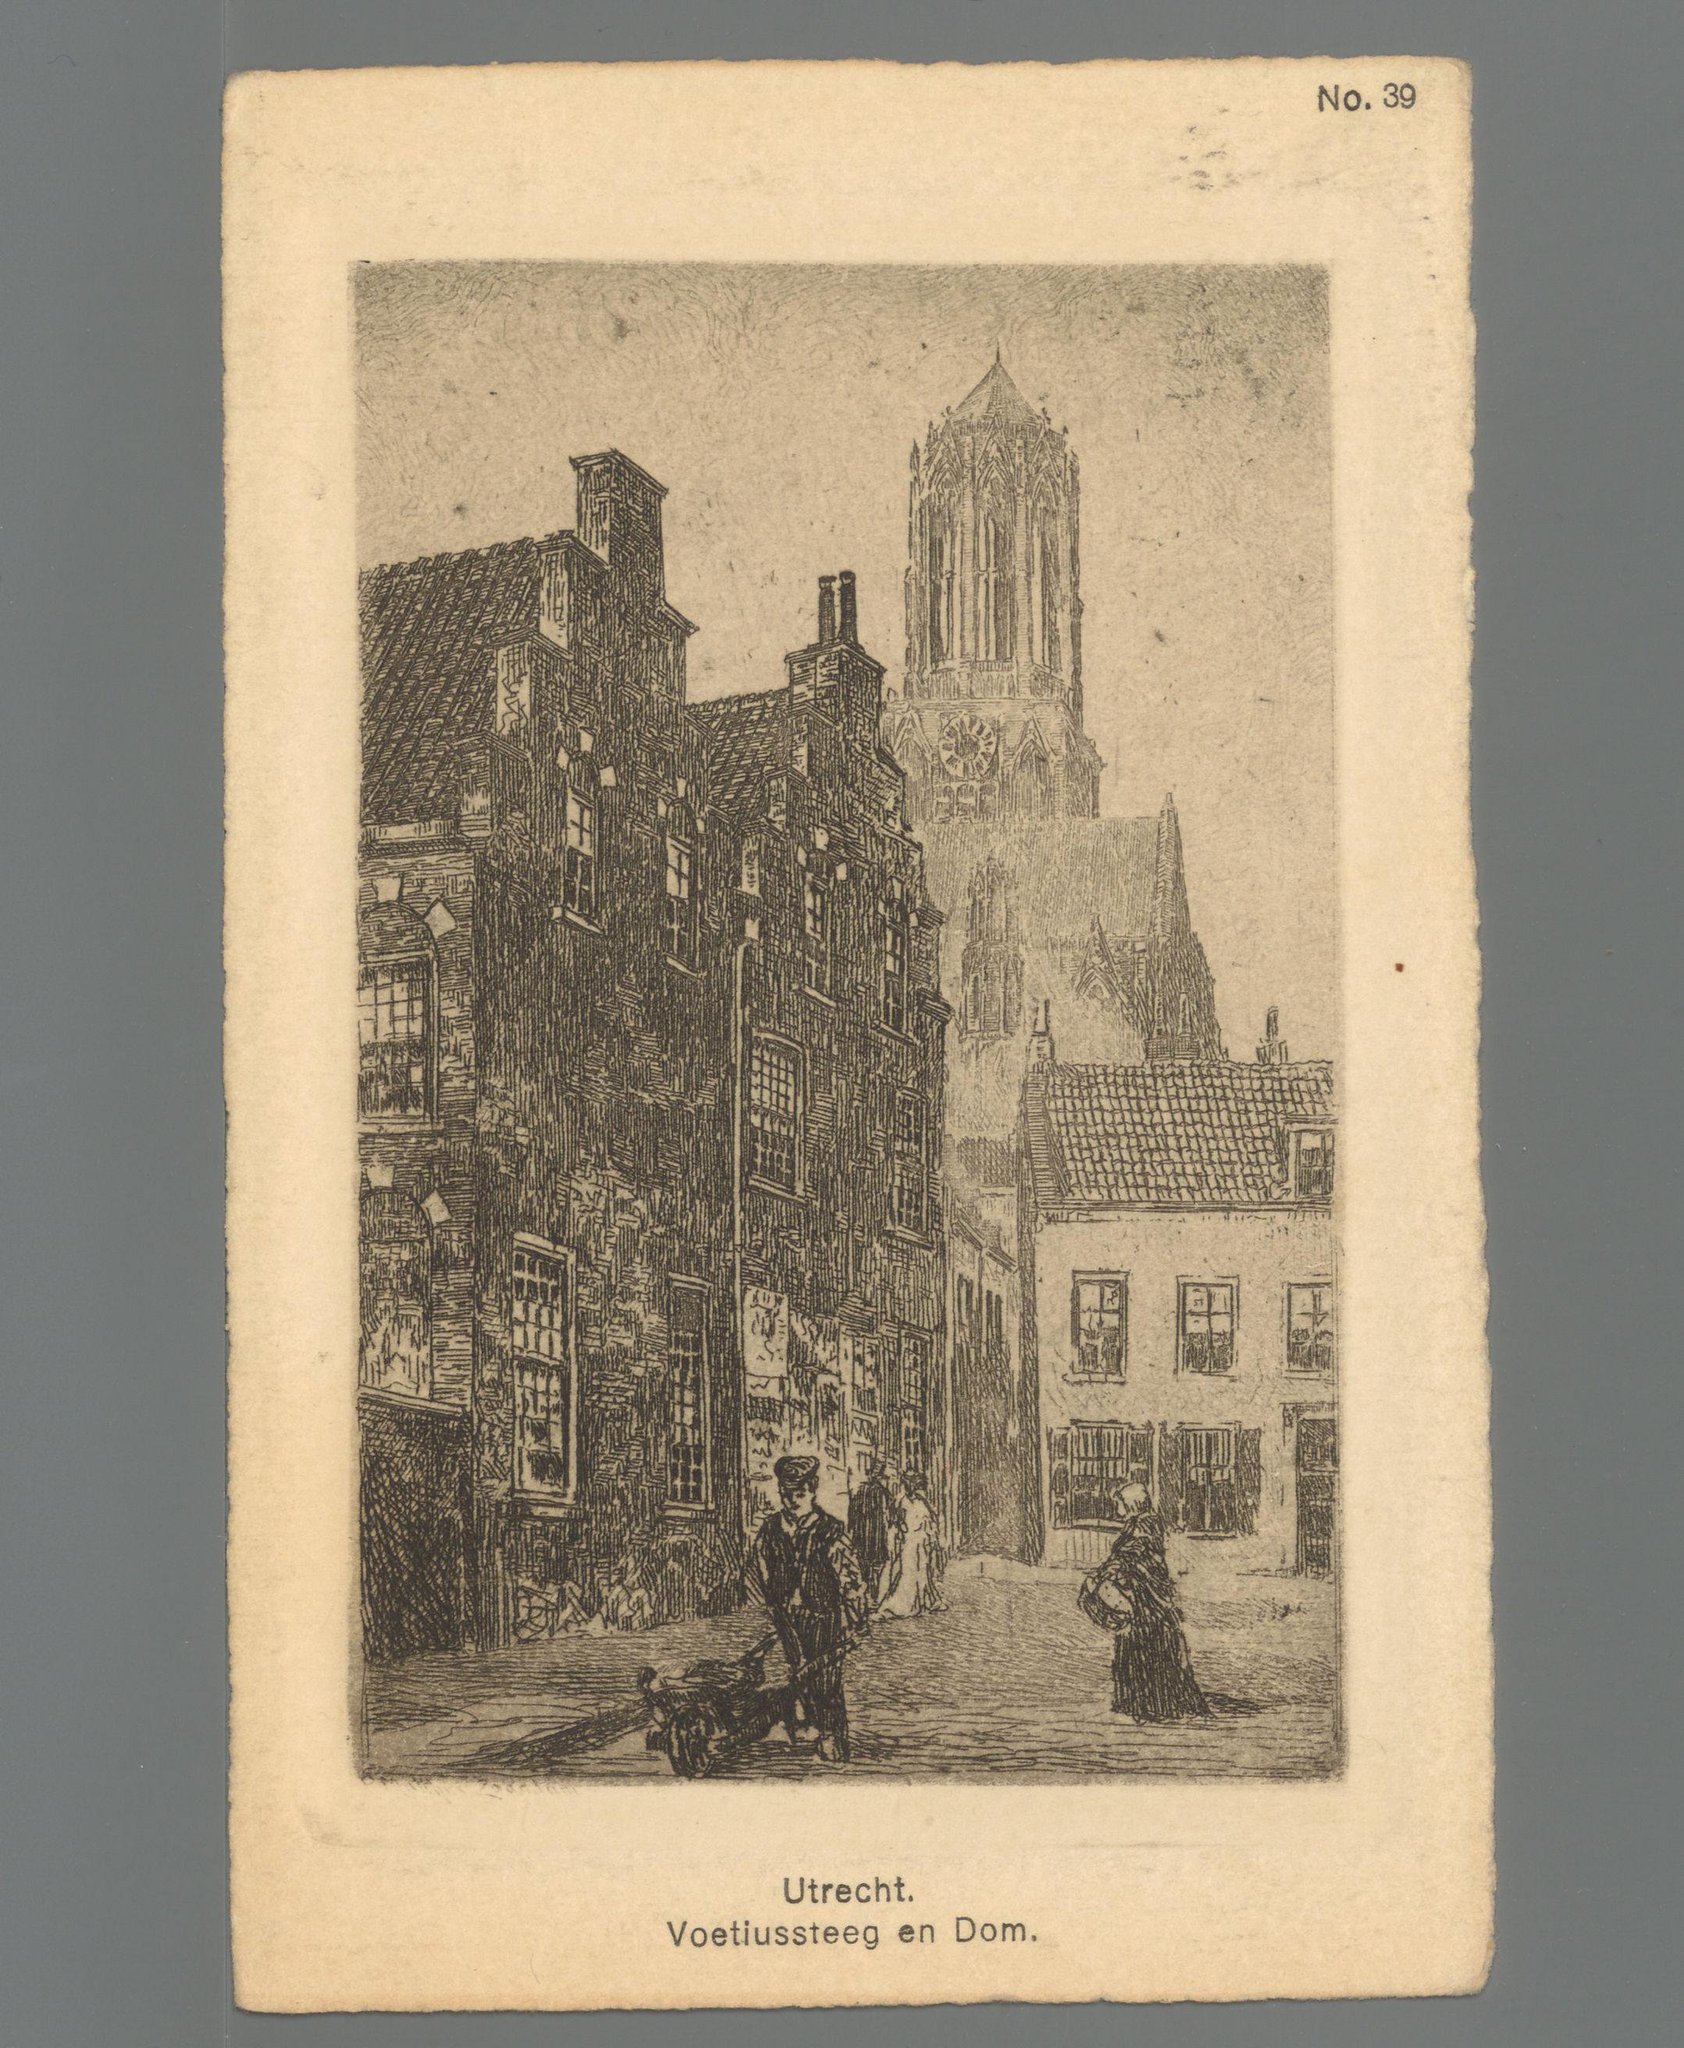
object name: photomechanical print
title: Utrecht. Voetiussteeg en Dom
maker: Anonymous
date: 1905-1926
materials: cardboard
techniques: photograph, writing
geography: utrecht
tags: church (exterior), city-view, and landscape with man-made constructions (+ city(-scape) with figures, staffage)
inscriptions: postage stamp